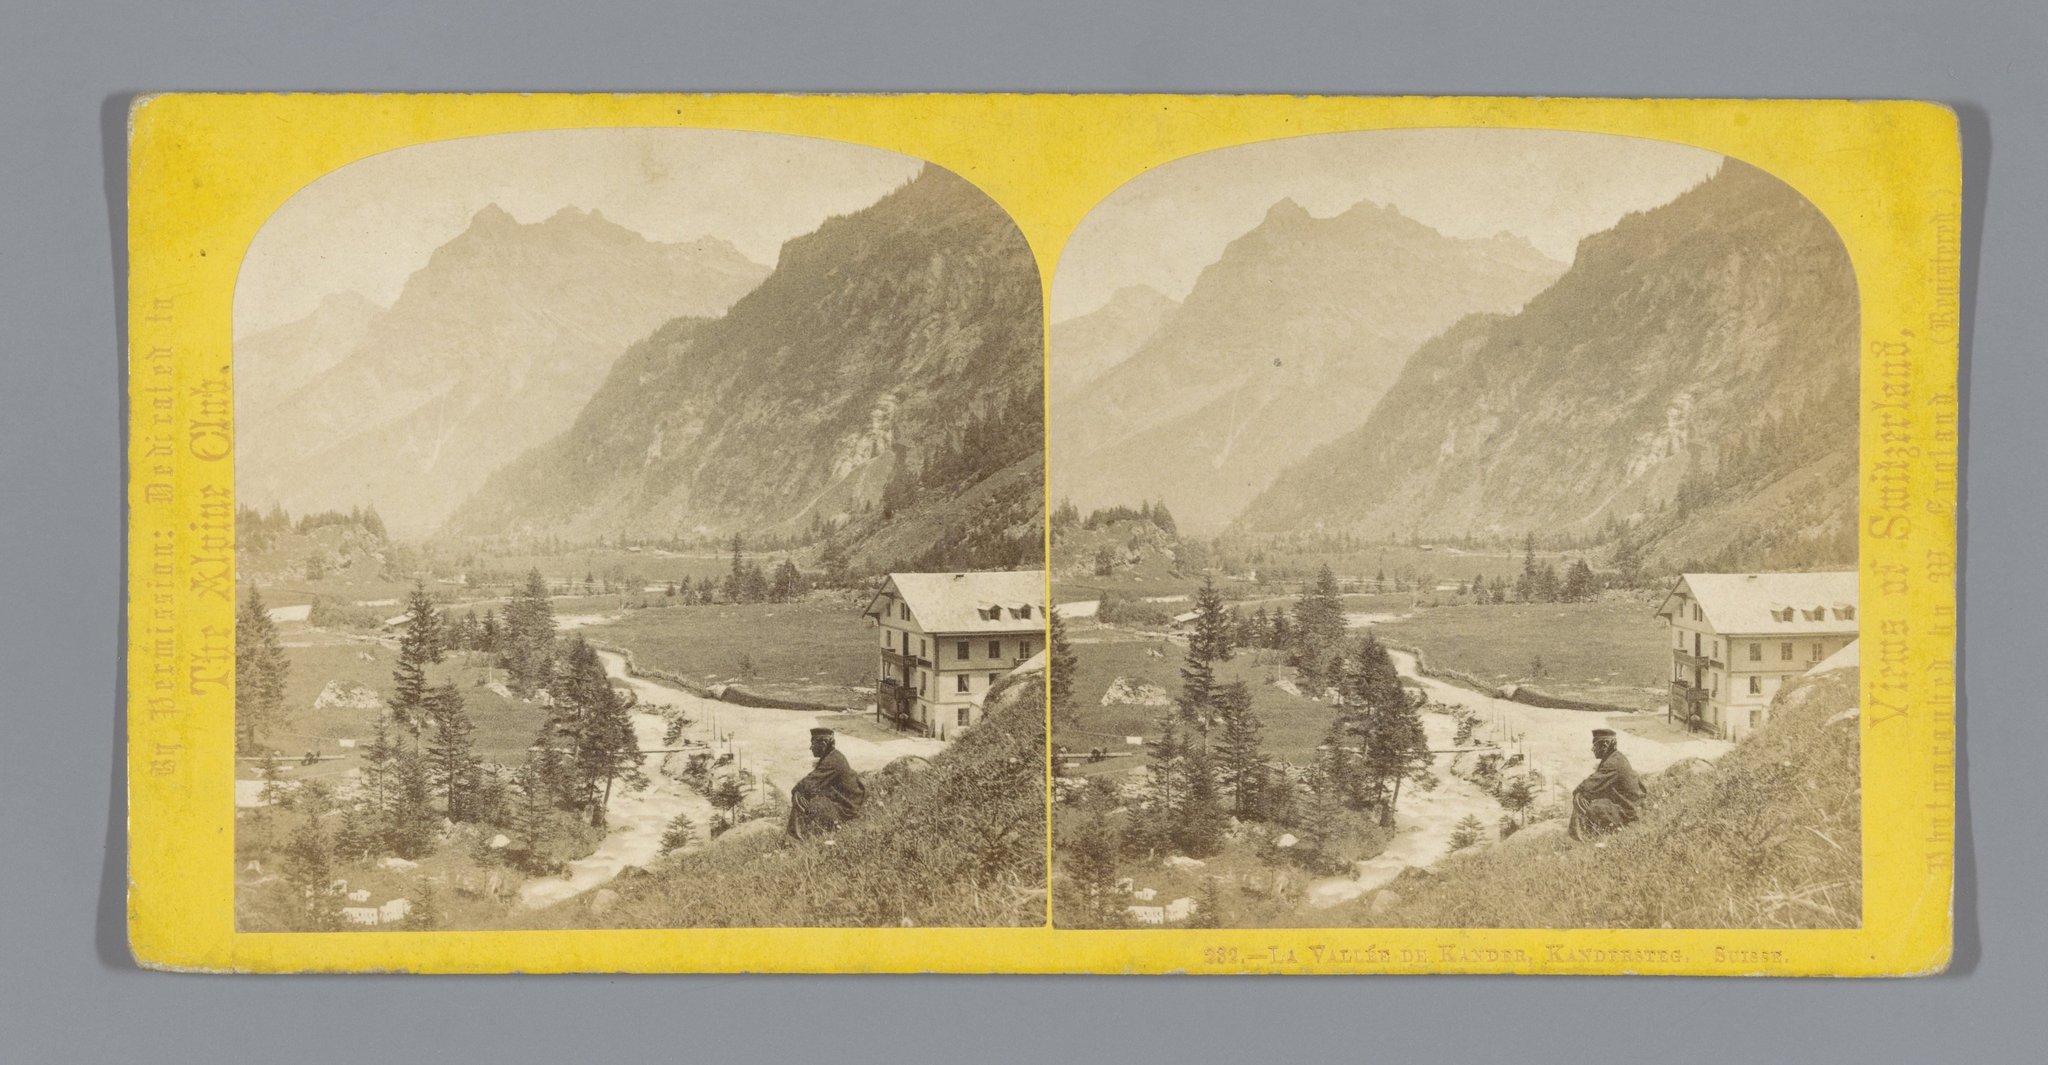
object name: stereograph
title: Gezicht op de Kandervallei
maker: william england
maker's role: fotograaf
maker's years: 1816-1896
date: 1850-1880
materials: cardboard, photographic support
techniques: albumen print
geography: bern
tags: dale, valley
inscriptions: number: ‘13.’, inscription: ‘Views of Switzerland, photographed by W. England. (Registered) Under the Special Patronage of the Alpine Club.’, number: ‘232.’